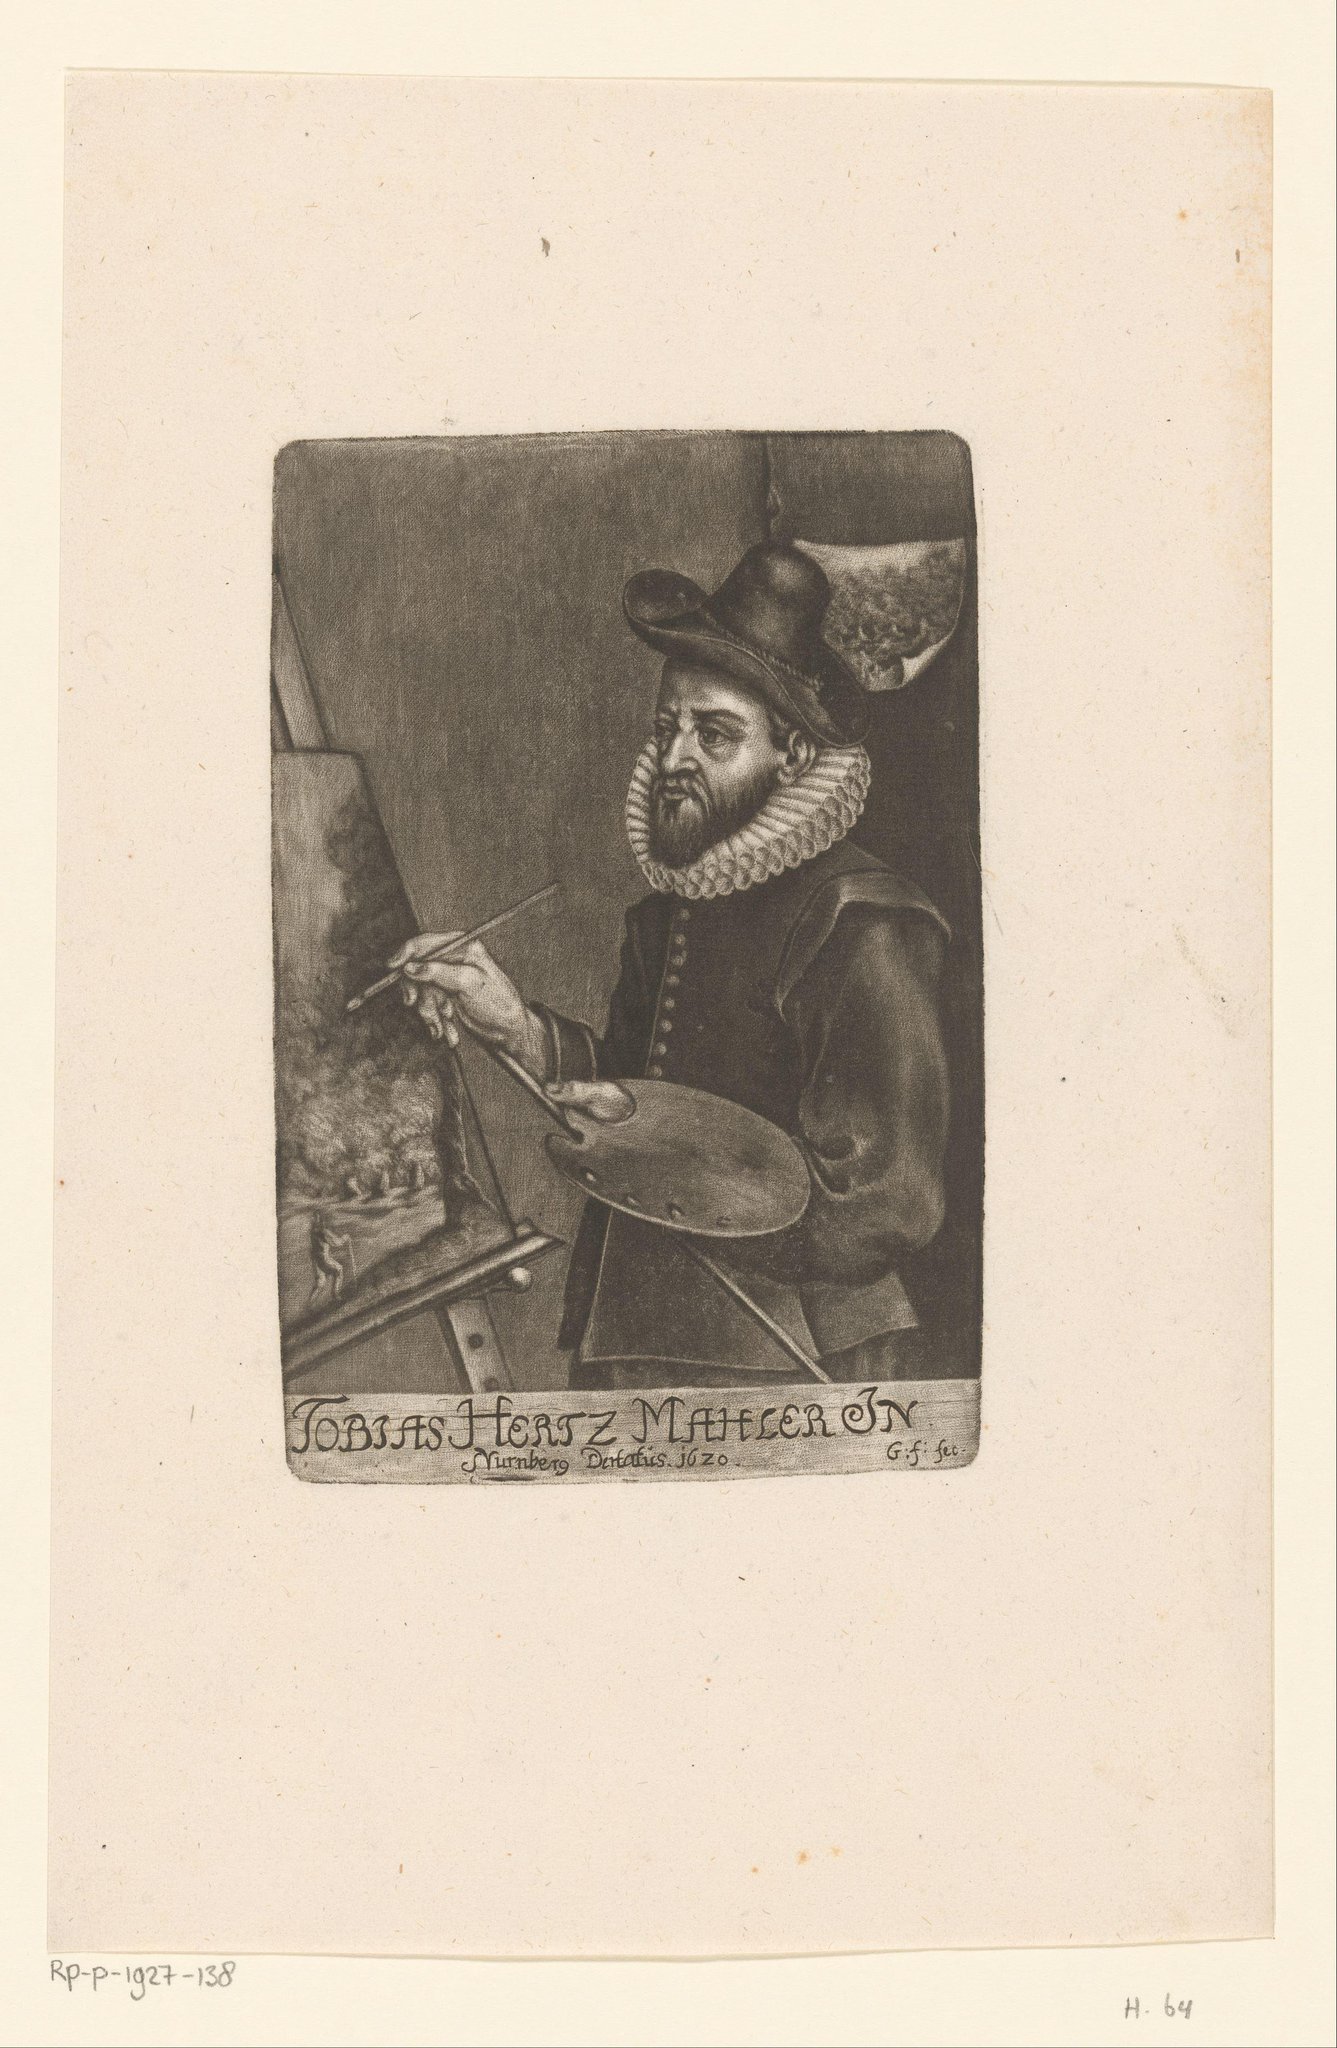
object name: print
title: Portret van Tobias Hertz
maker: georg fennitzer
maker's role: print maker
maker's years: 1646-1722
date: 1656-1722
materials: paper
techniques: mezzotint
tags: historical persons, portrait, self-portrait of painter, painting (including book-illumination, miniature-painting)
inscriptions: collector's mark: Lugt 2166